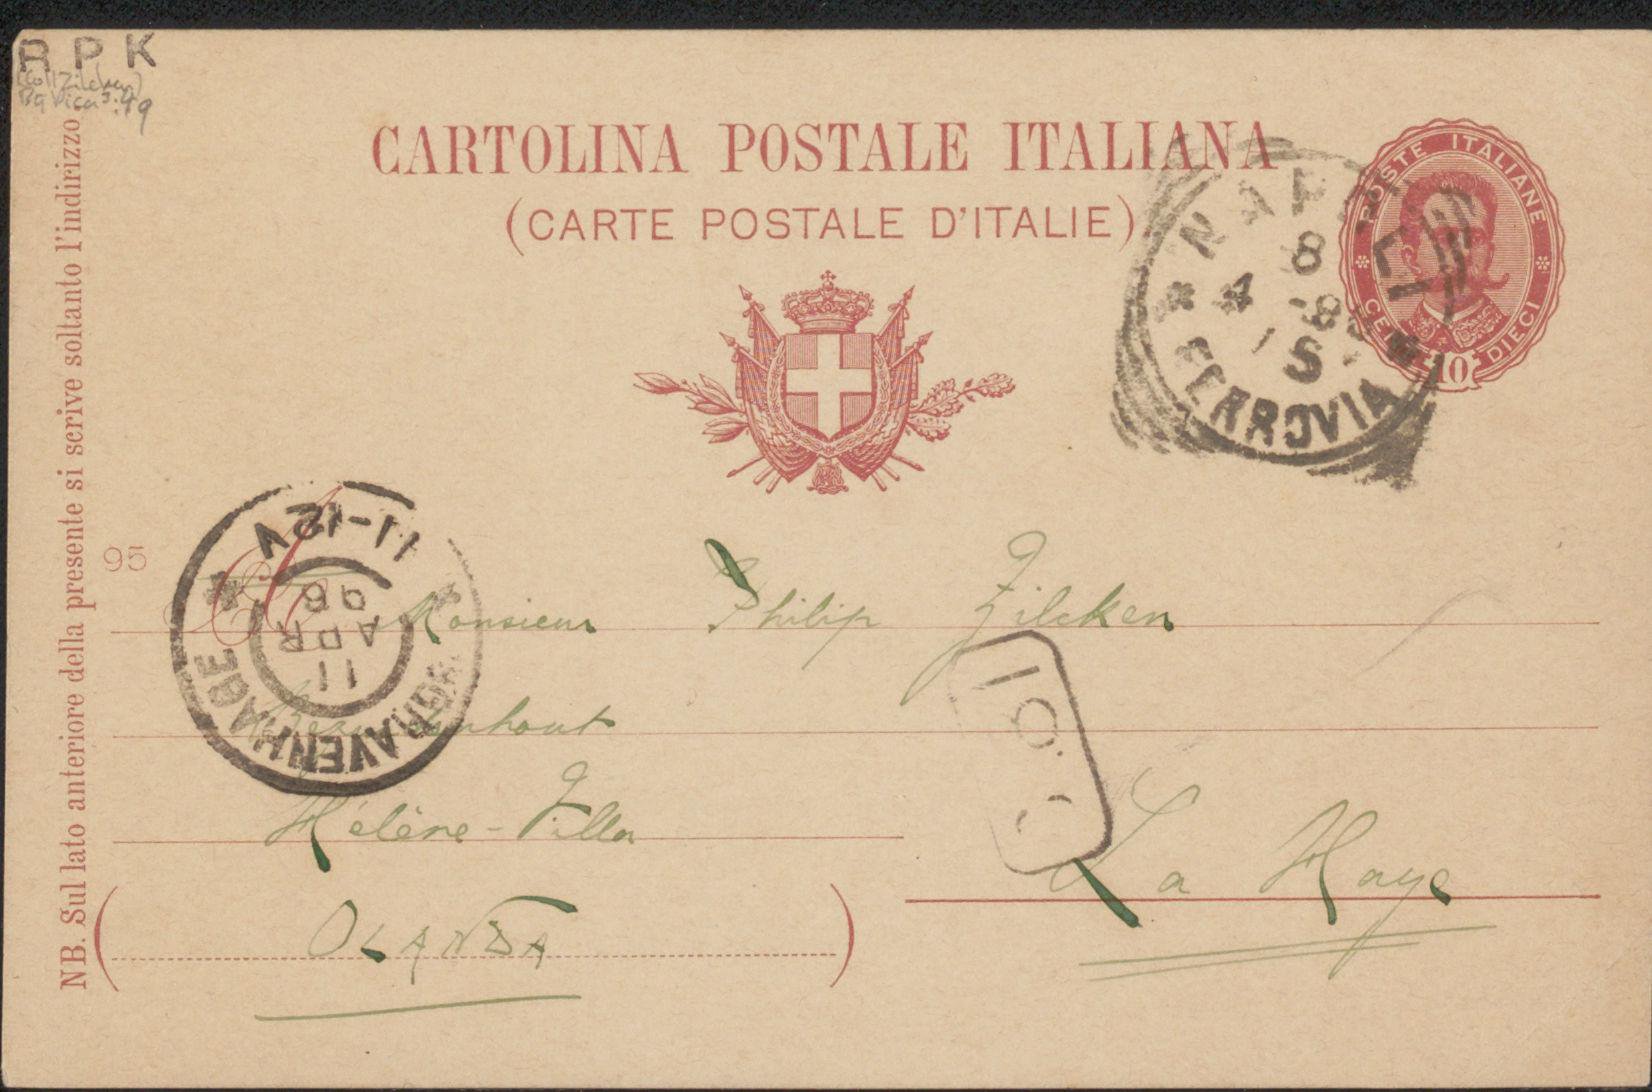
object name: postcard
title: Briefkaart aan Philip Zilcken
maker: vittorio pica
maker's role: criticus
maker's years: 1864-1930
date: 1896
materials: cardboard, ink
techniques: pen, writing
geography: naples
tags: renée hélène laure zilcken, the hague, painter, draughtsman, philip zilcken, photography, cinematography, naples, holland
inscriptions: collector's mark: ‘RPK’